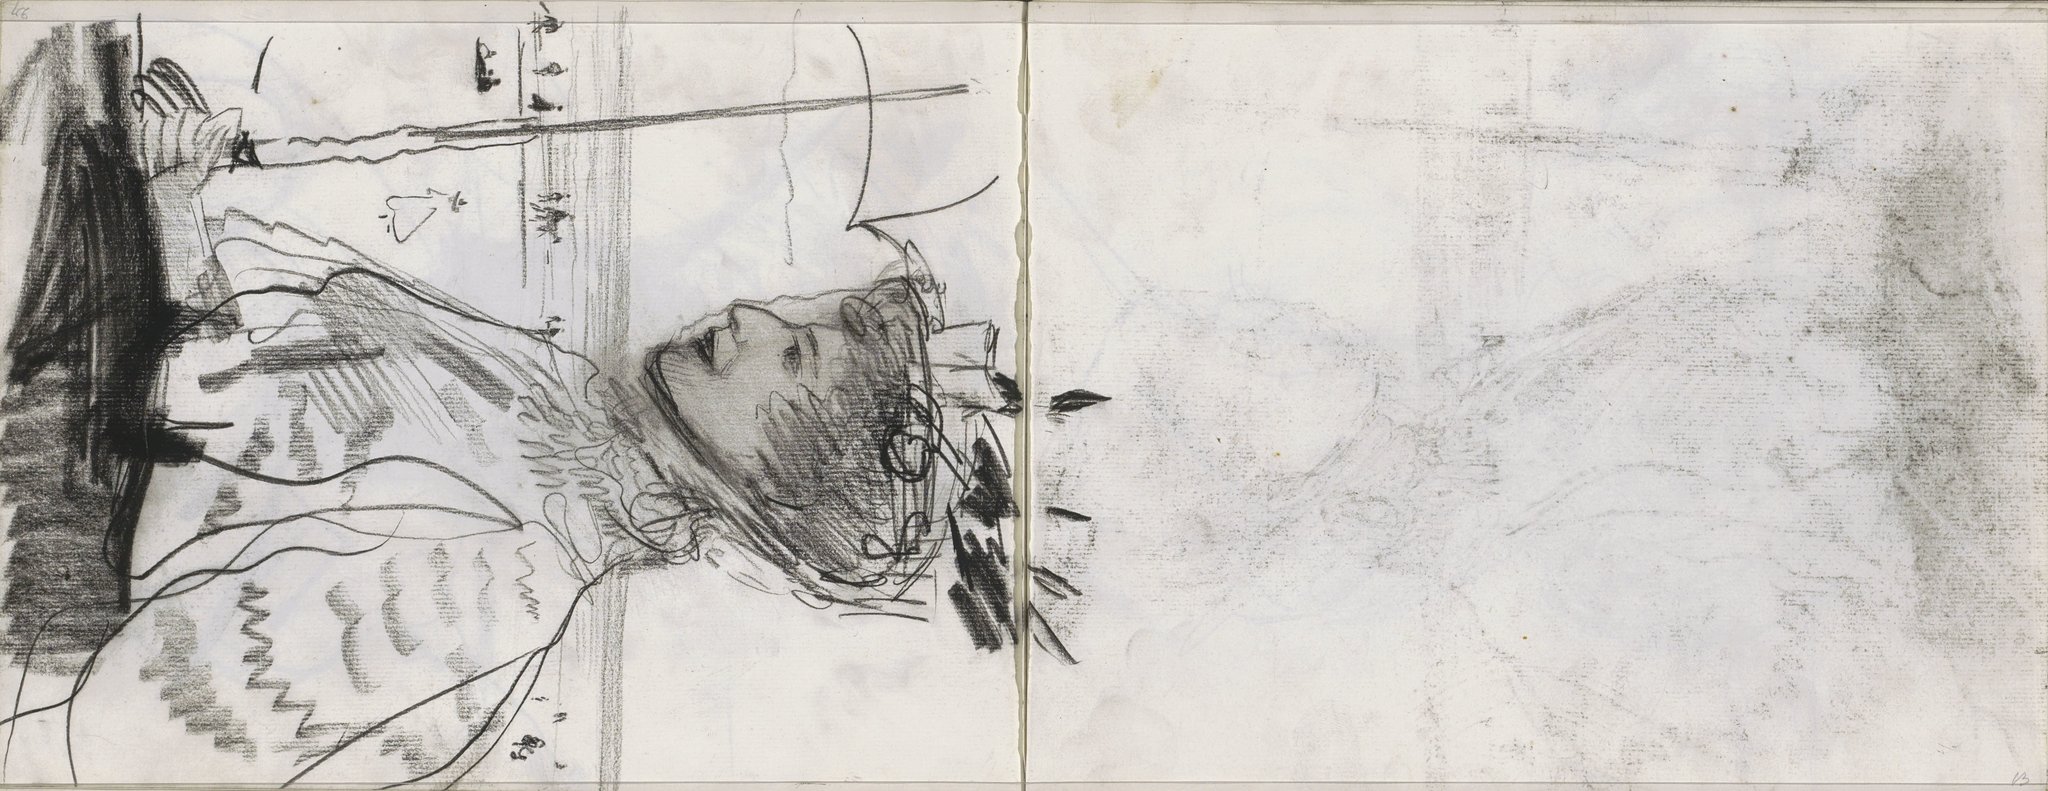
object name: sketchbook leaf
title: Vrouw met parasol op het strand, in profiel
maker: isaac israels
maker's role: draughtsman, painter, print maker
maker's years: 1865-1934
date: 1875-1934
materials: chalk, paper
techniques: stumping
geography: the hague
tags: adult woman (+ sideview, profile), parasol, sunshade, beach (+ landscape with figures, staffage)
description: Op de achtergrond figuren. Blad 12 verso en blad 13 recto uit schetsboek XXI met 19 bladen.